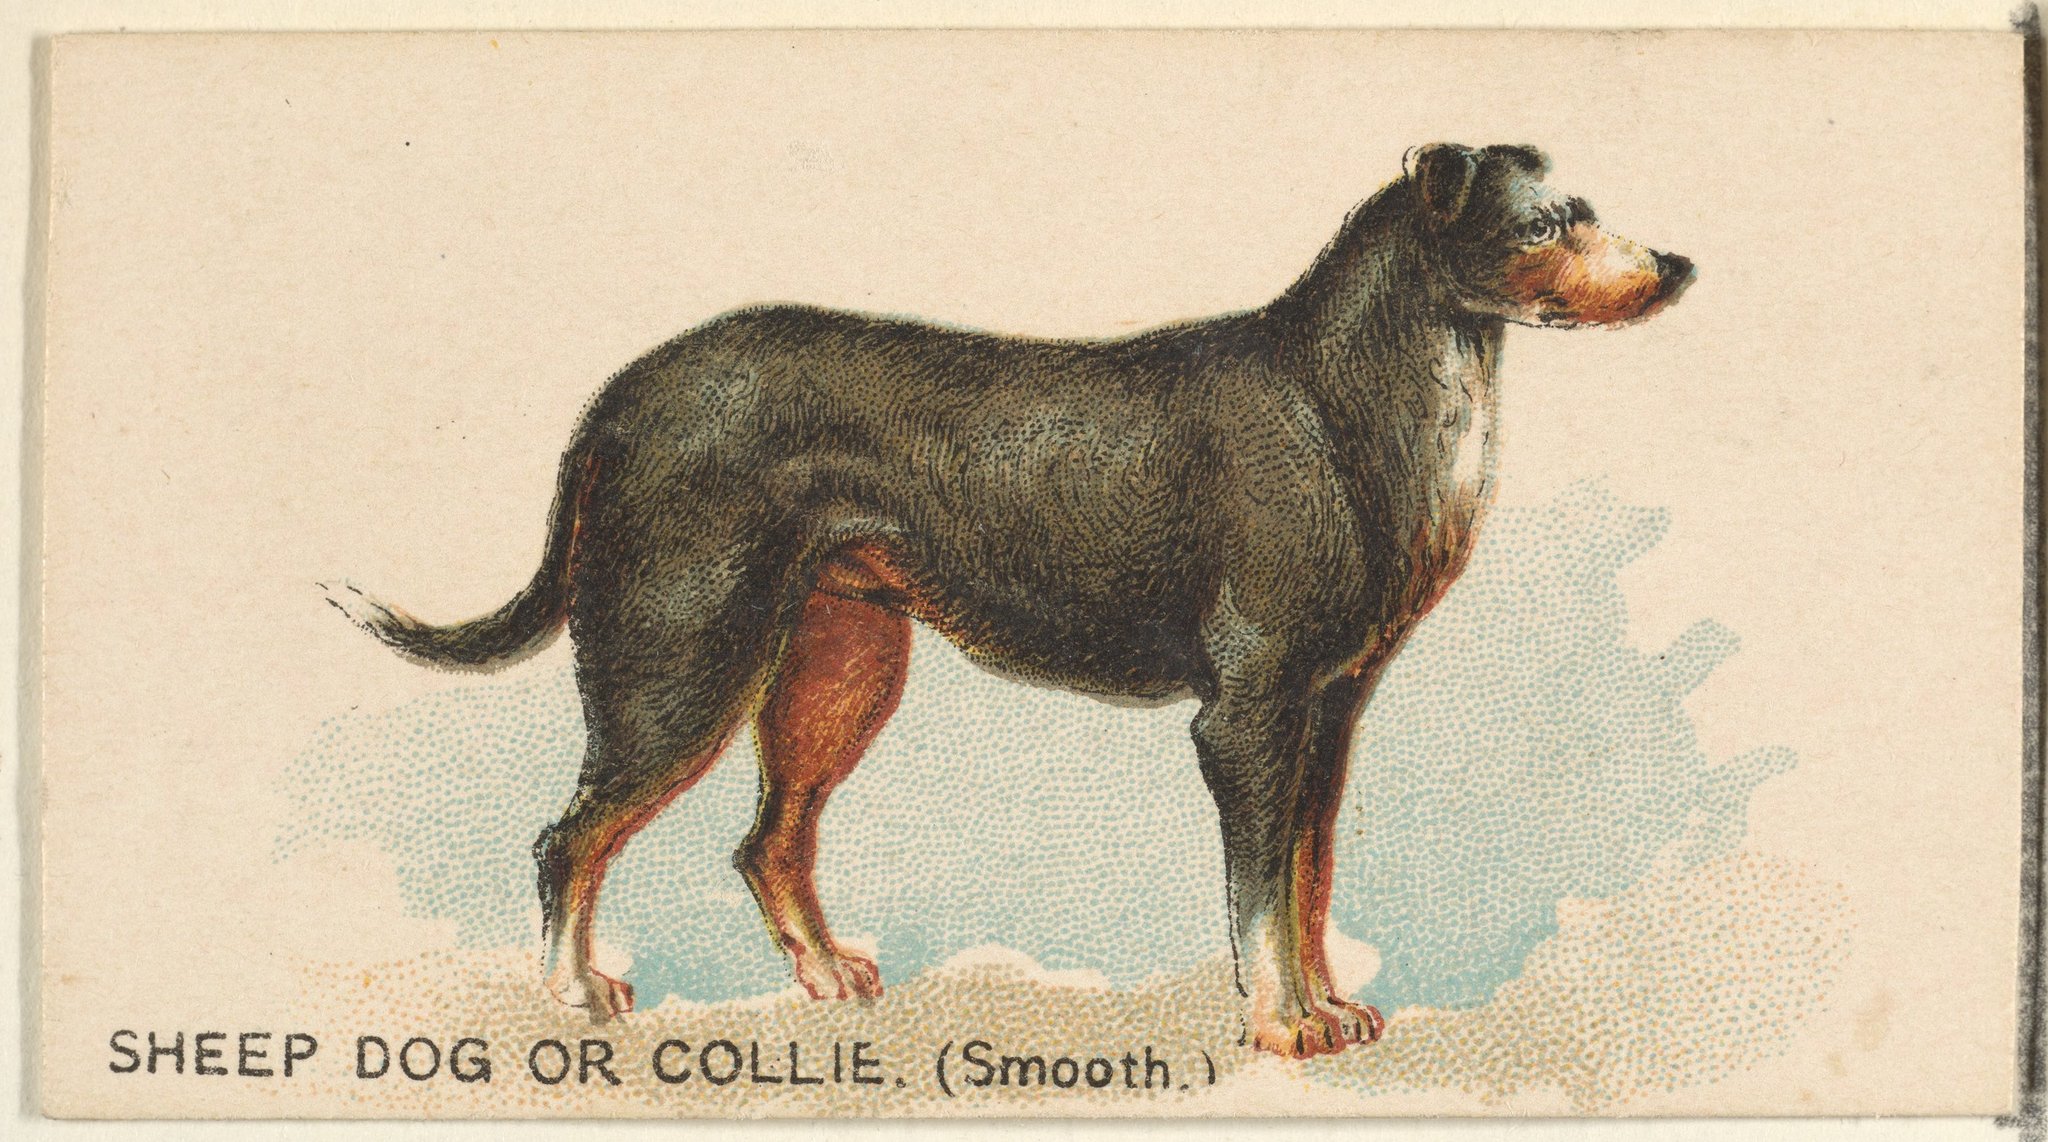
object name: print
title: Sheep Dog or Collie (Smooth), from the Dogs of the World series for Old Judge Cigarettes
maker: goodwin & company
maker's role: publisher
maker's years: 1850-1950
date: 1890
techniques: color lithograph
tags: dogs